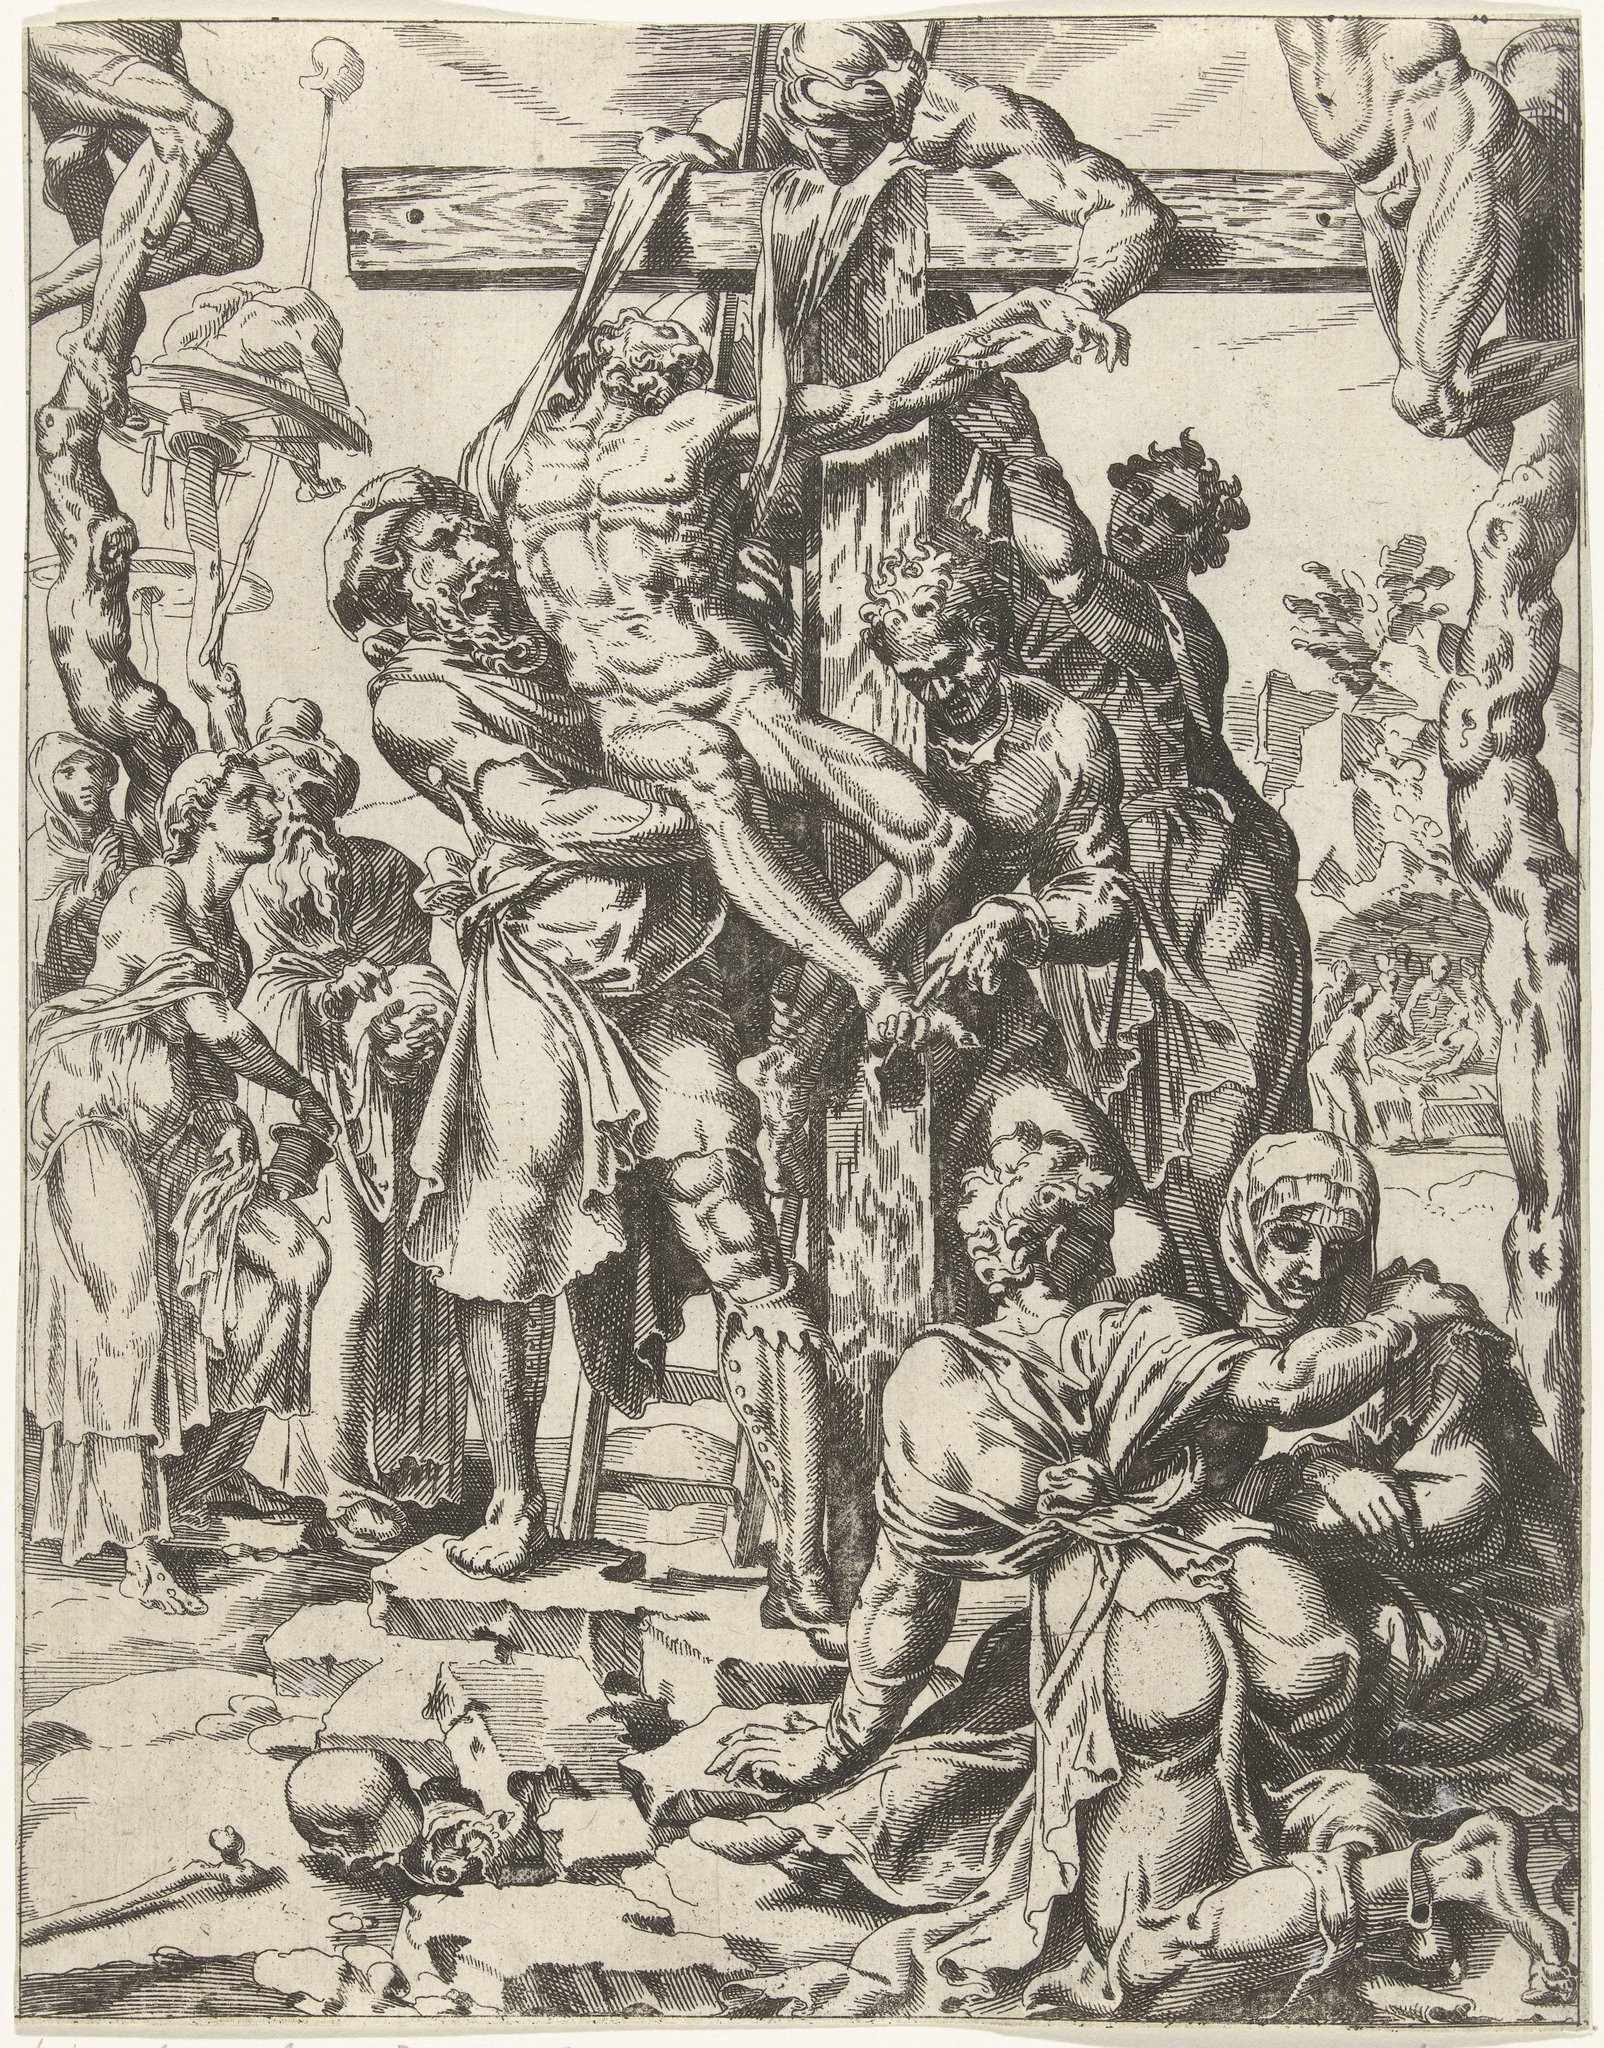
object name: print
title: Val en de verlossing van de mensheid door het leven en passie van Christus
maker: dirck volckertsz. coornhert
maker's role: draughtsman, print maker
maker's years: 1522-1590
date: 1548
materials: paper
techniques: etching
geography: haarlem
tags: descent from the cross: christ is taken down from the cross, usually by nicodemus and joseph of arimathaea who are standing on the ladders (both arms of christ detached)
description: Christus wordt het kruis afgenomen door Jozef van Arimatea en Nikodemus. Anderen helpen. De prent is deel van een dertigdelige serie met prenten over de zondeval en Christus' passie.